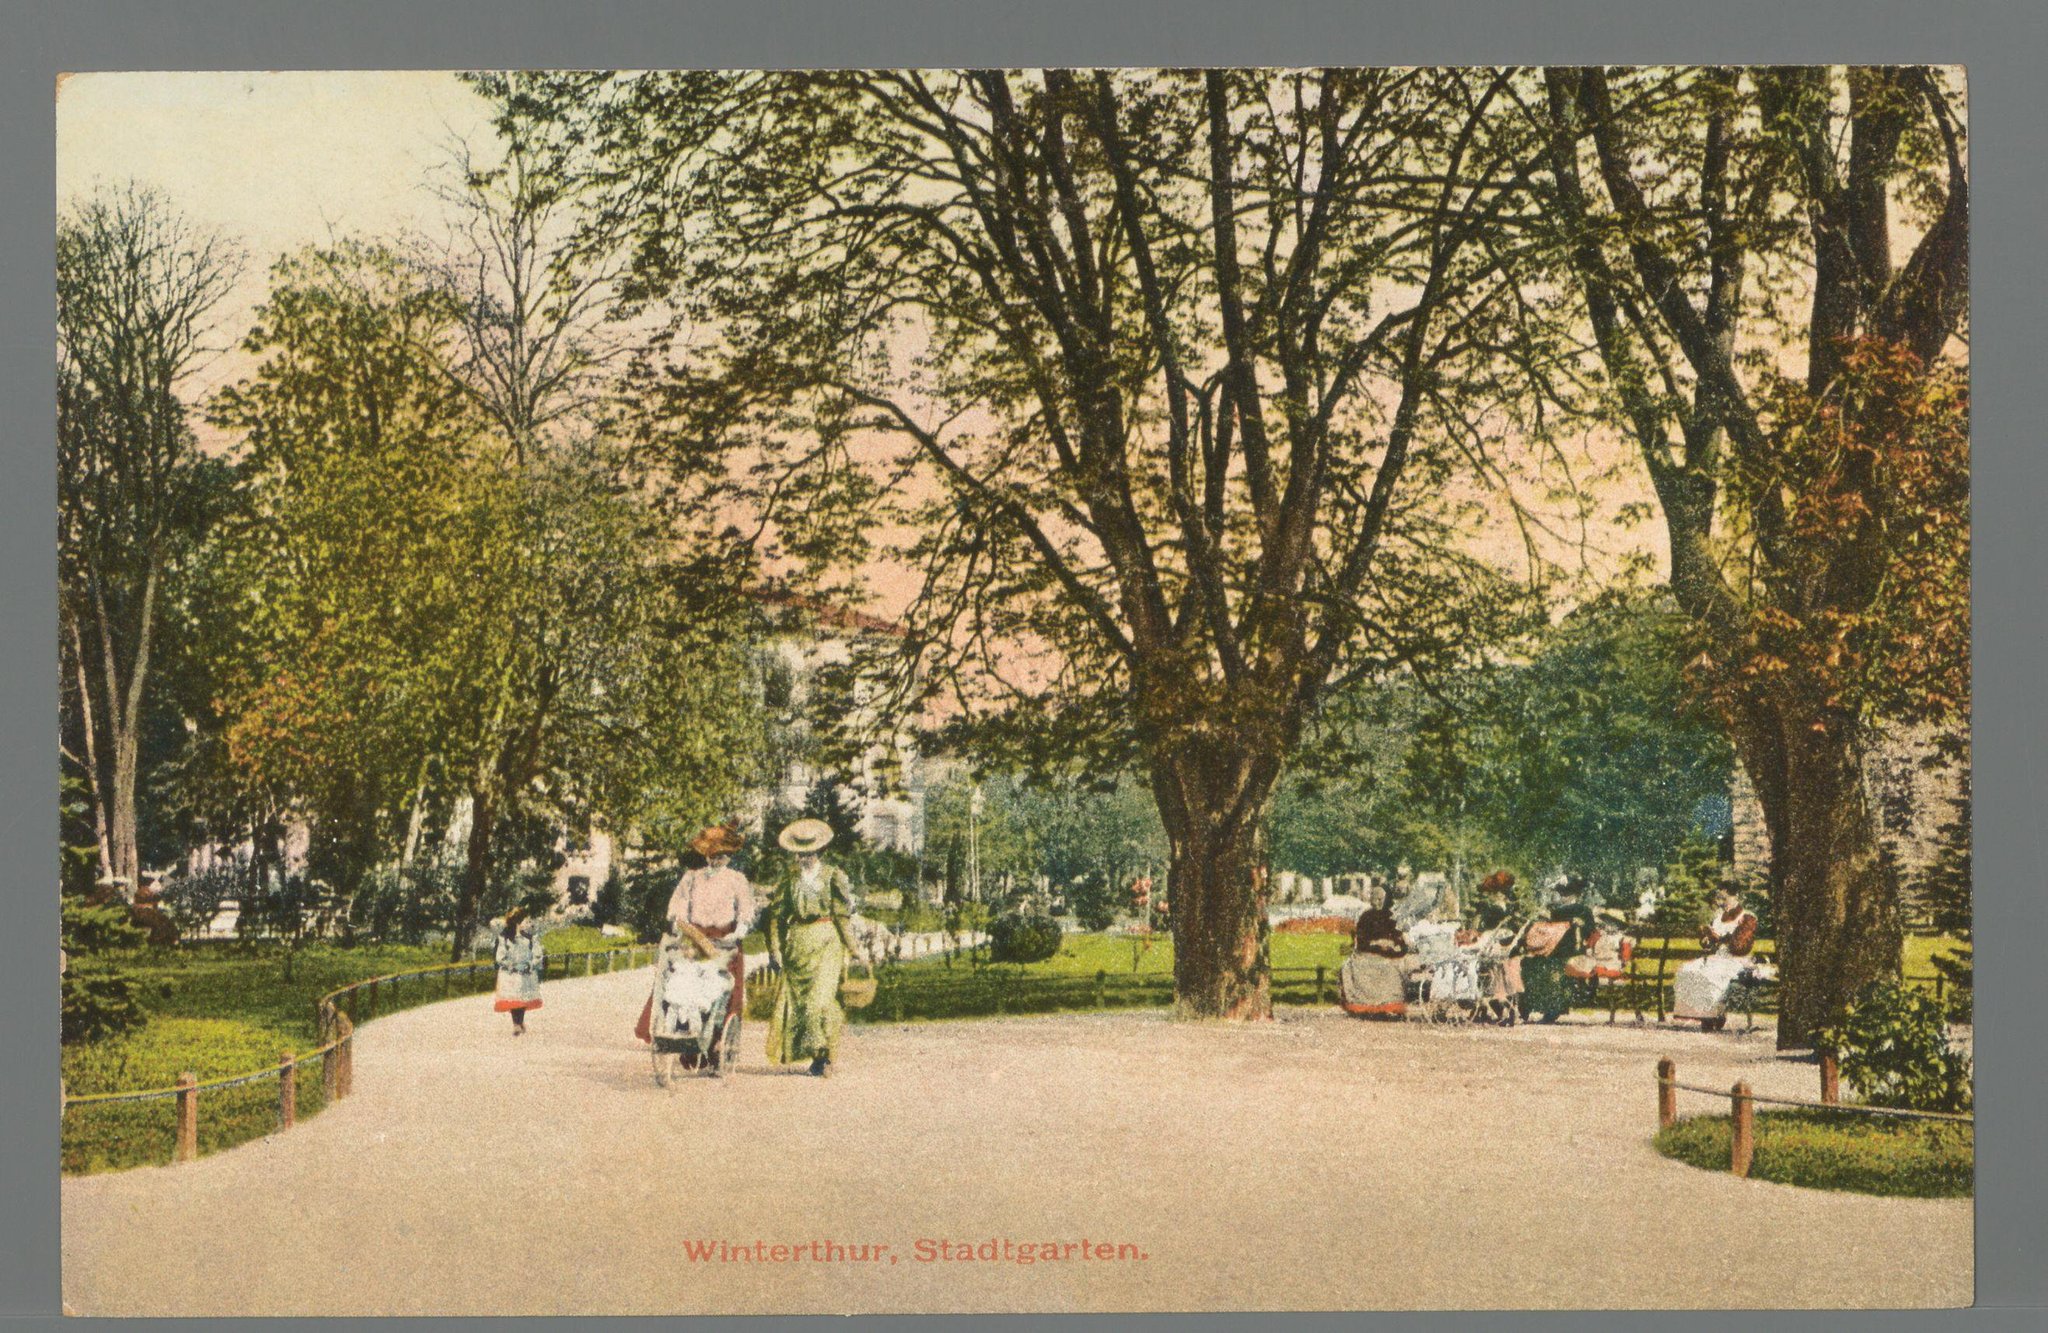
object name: ansichtkaart, prentbriefkaart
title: Winterthur. Stadtgarten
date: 1905-1920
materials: cardboard, photographic process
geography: zurich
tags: trees, public gardens, park (+ city(-scape) with figures, staffage)